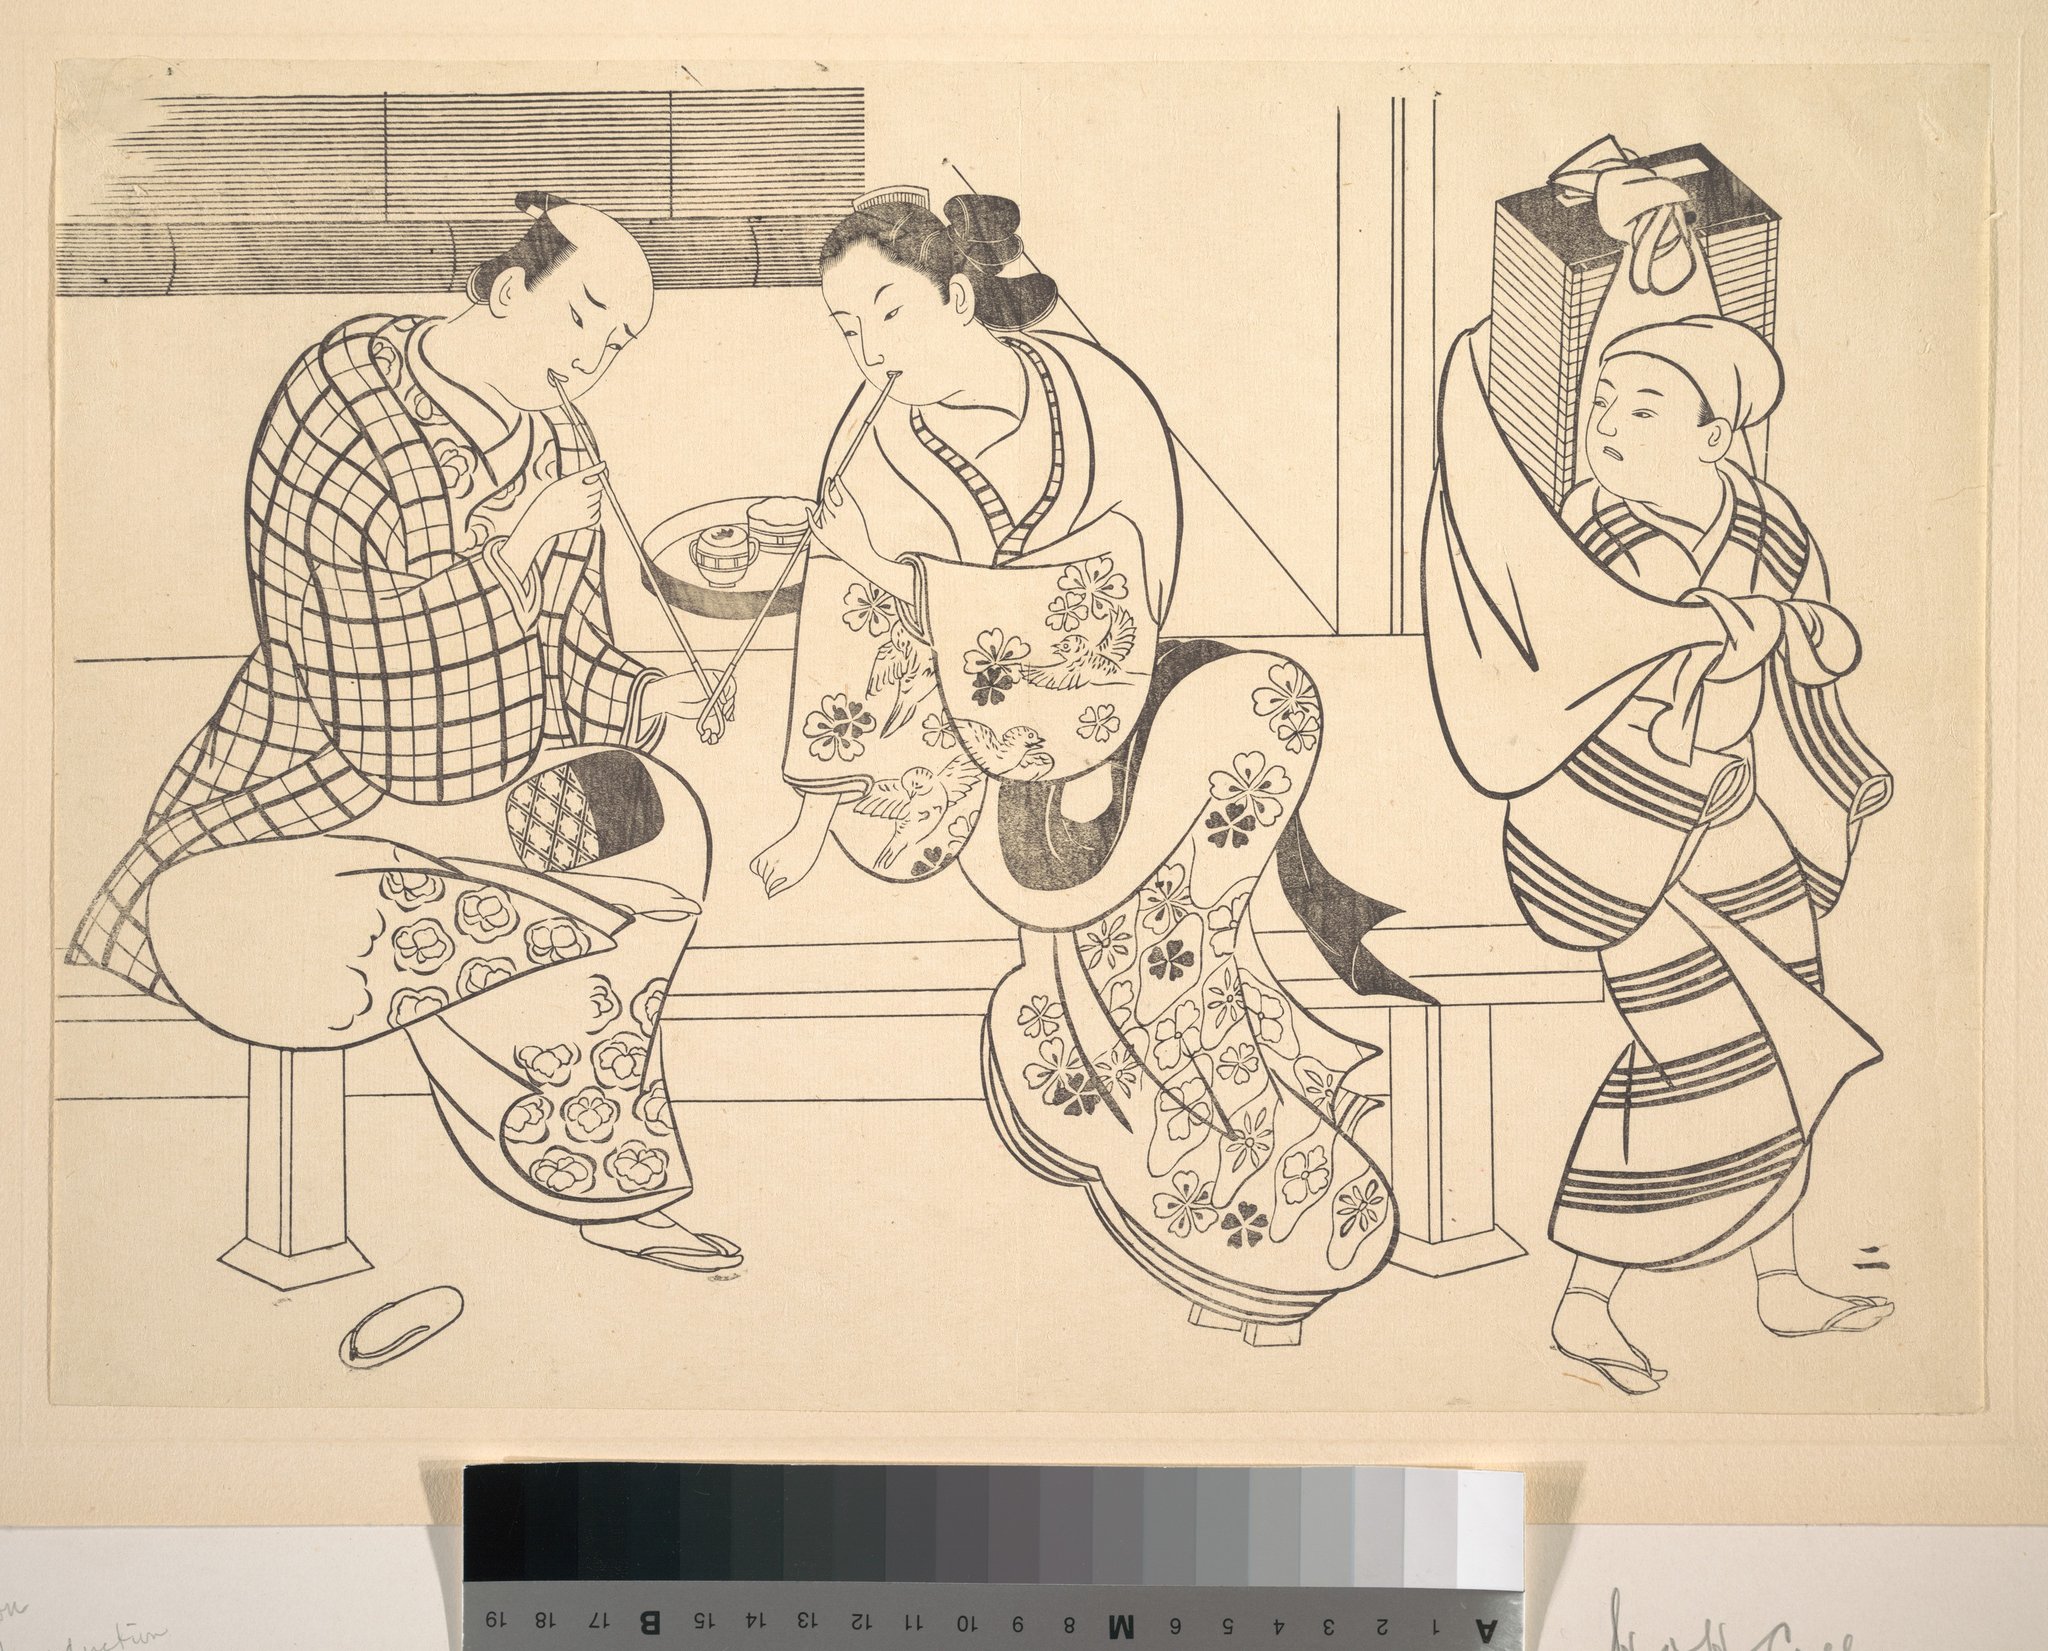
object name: print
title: A Man Lighting His Pipe from that of A Young Woman who Sits Beside Him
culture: japanese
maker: okumura masanobu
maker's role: artist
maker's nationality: japanese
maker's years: 1686-1764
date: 1868-1912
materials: ink, paper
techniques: woodblock print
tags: men,women,smoking